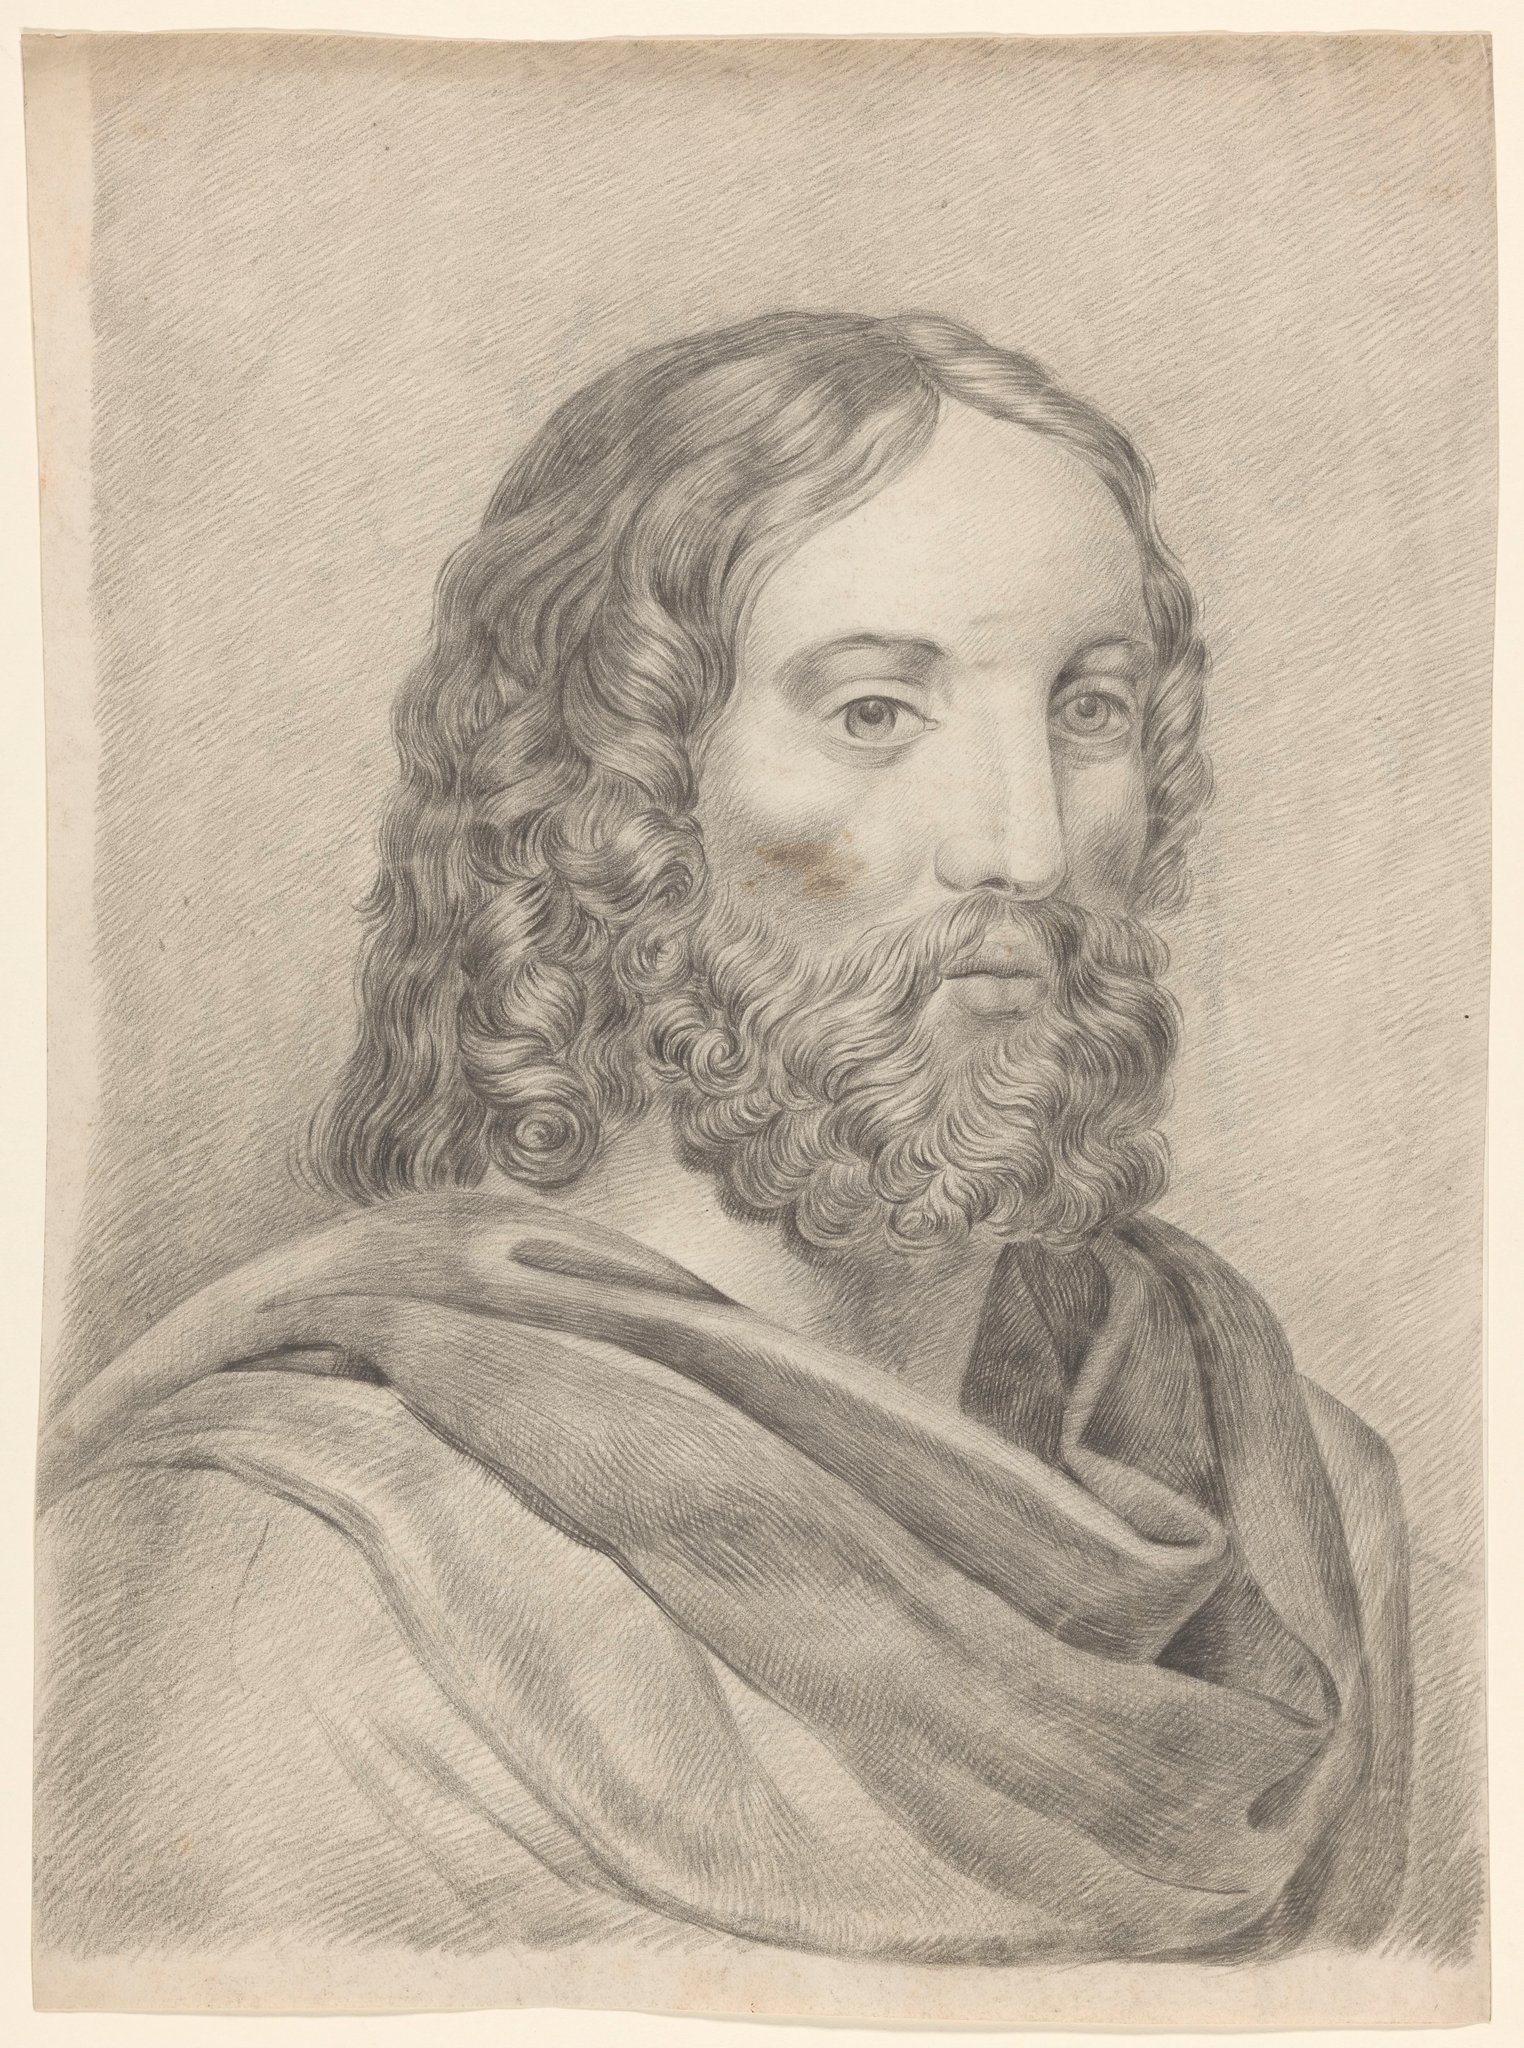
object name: figuurstudie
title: Buste van een man met baard (Christus?)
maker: johannes tavenraat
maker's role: draughtsman, painter, print maker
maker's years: 1809-1881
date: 1819-1881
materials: chalk, paper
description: Academiestudie naar een geschilderd of getekend werk.